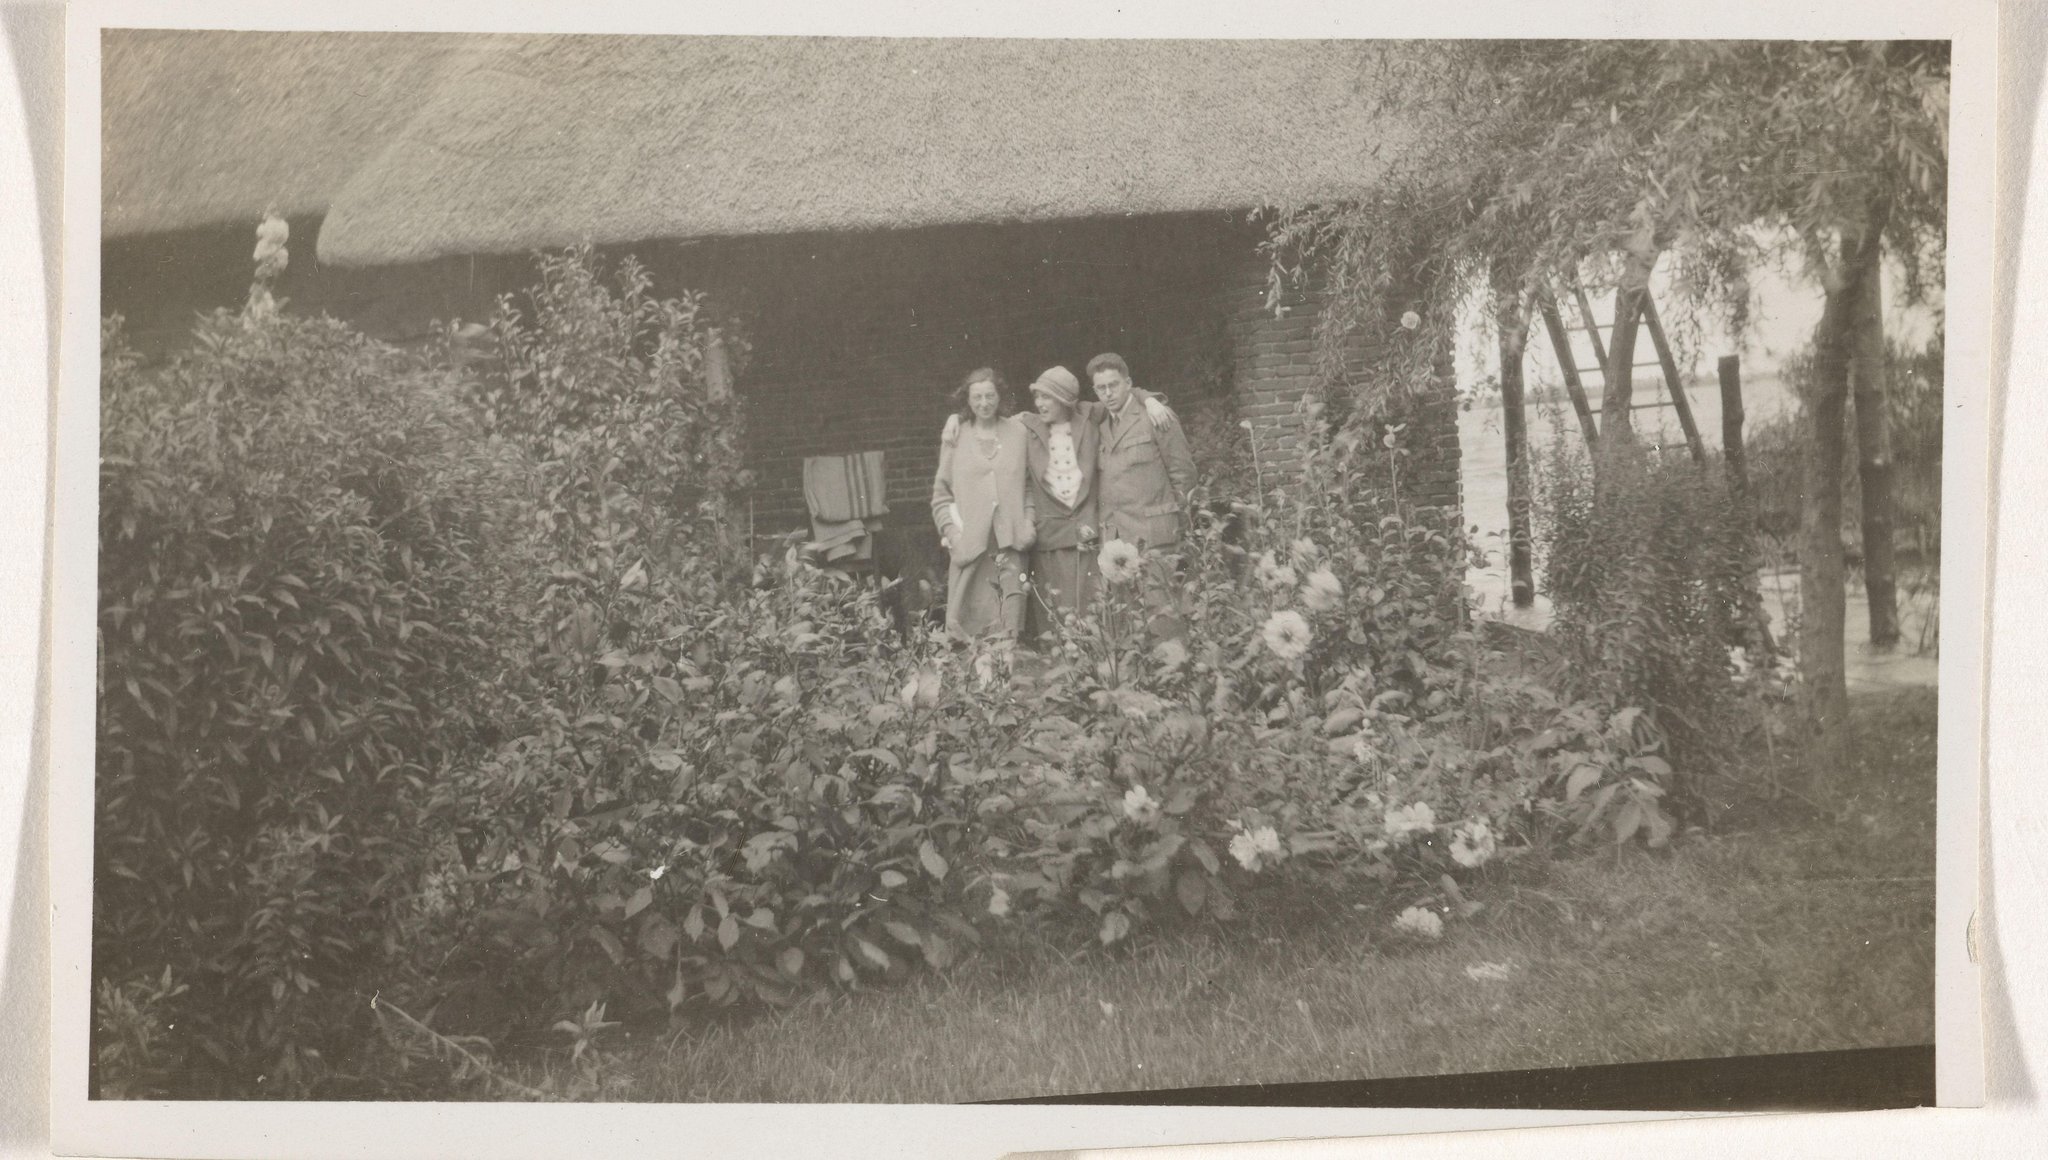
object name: photograph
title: Irene With met twee onbekende personen in een tuin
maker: Anonymous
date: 1930-1937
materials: paper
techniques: gelatin silver print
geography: germany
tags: amsterdam, garden, germany